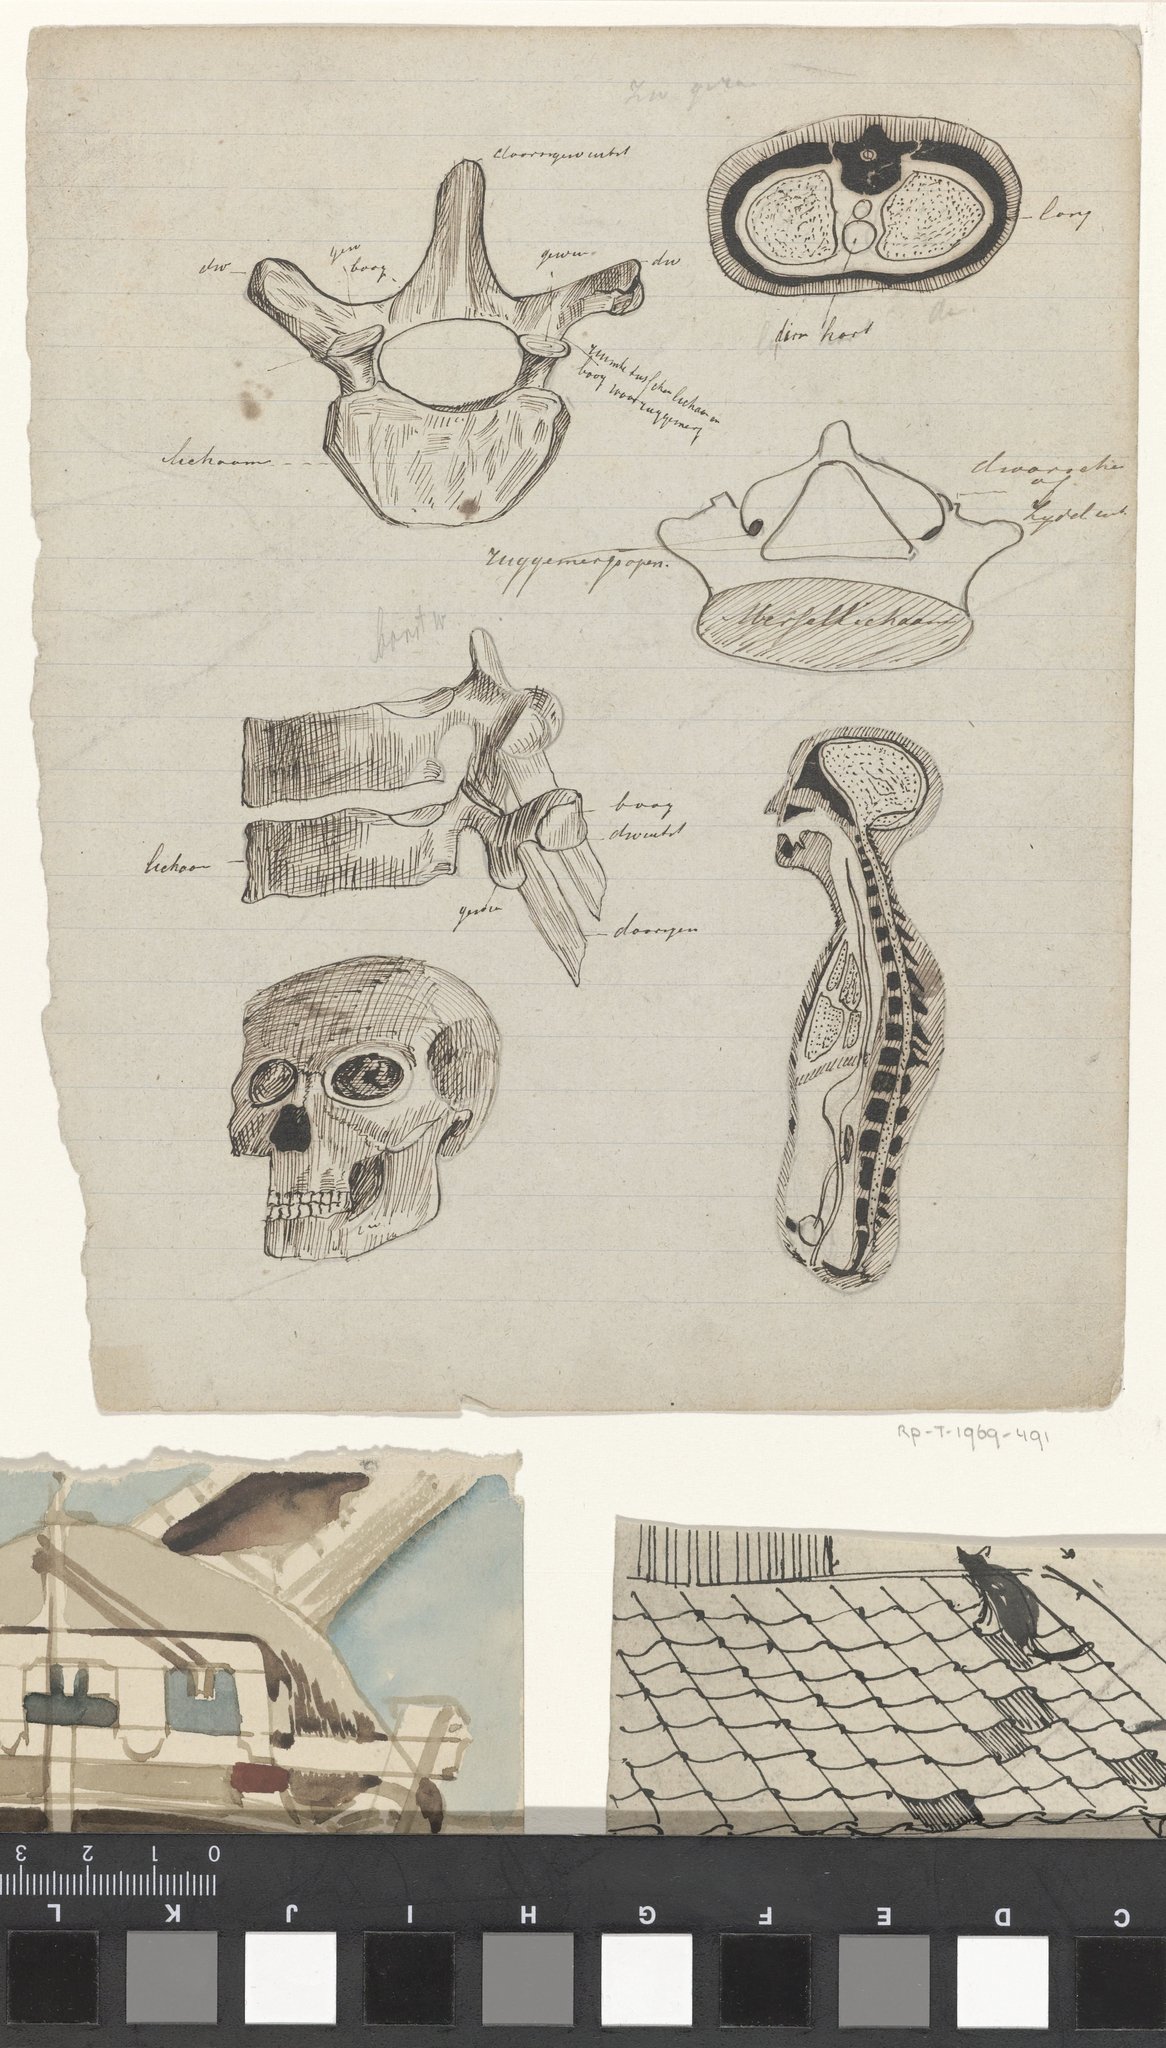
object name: drawing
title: Studies van menselijke anatomie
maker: carel adolph lion cachet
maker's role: draughtsman, print maker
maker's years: 1864-1945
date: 1874-1945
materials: ink, paper, pencil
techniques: pen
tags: spine, (human) skull, bones in general (human body)